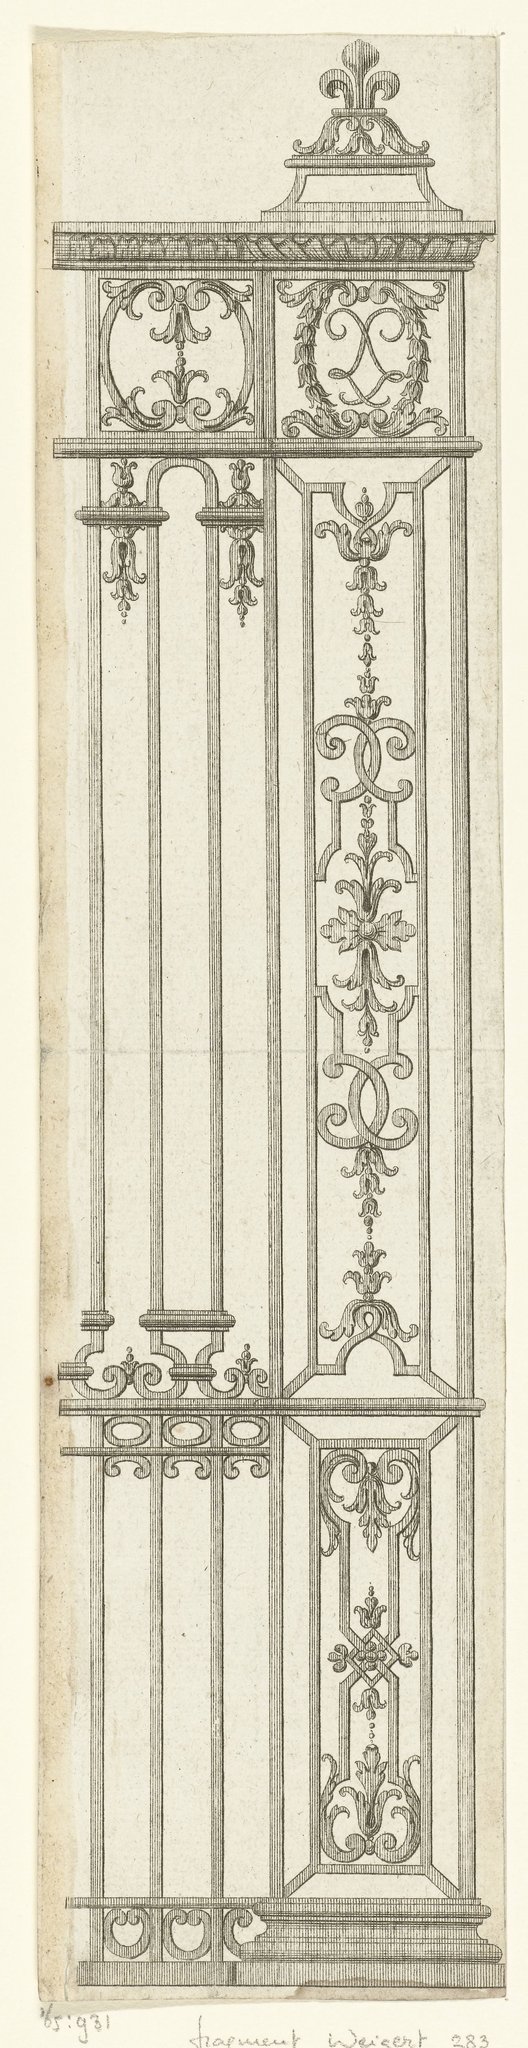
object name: print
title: Poort met hoekpilaster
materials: paper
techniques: etching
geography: france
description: Met bovenaan het monogram van Louis XIV. Fragment van blad 4 uit serie van 5 bladen. Tweede editie.